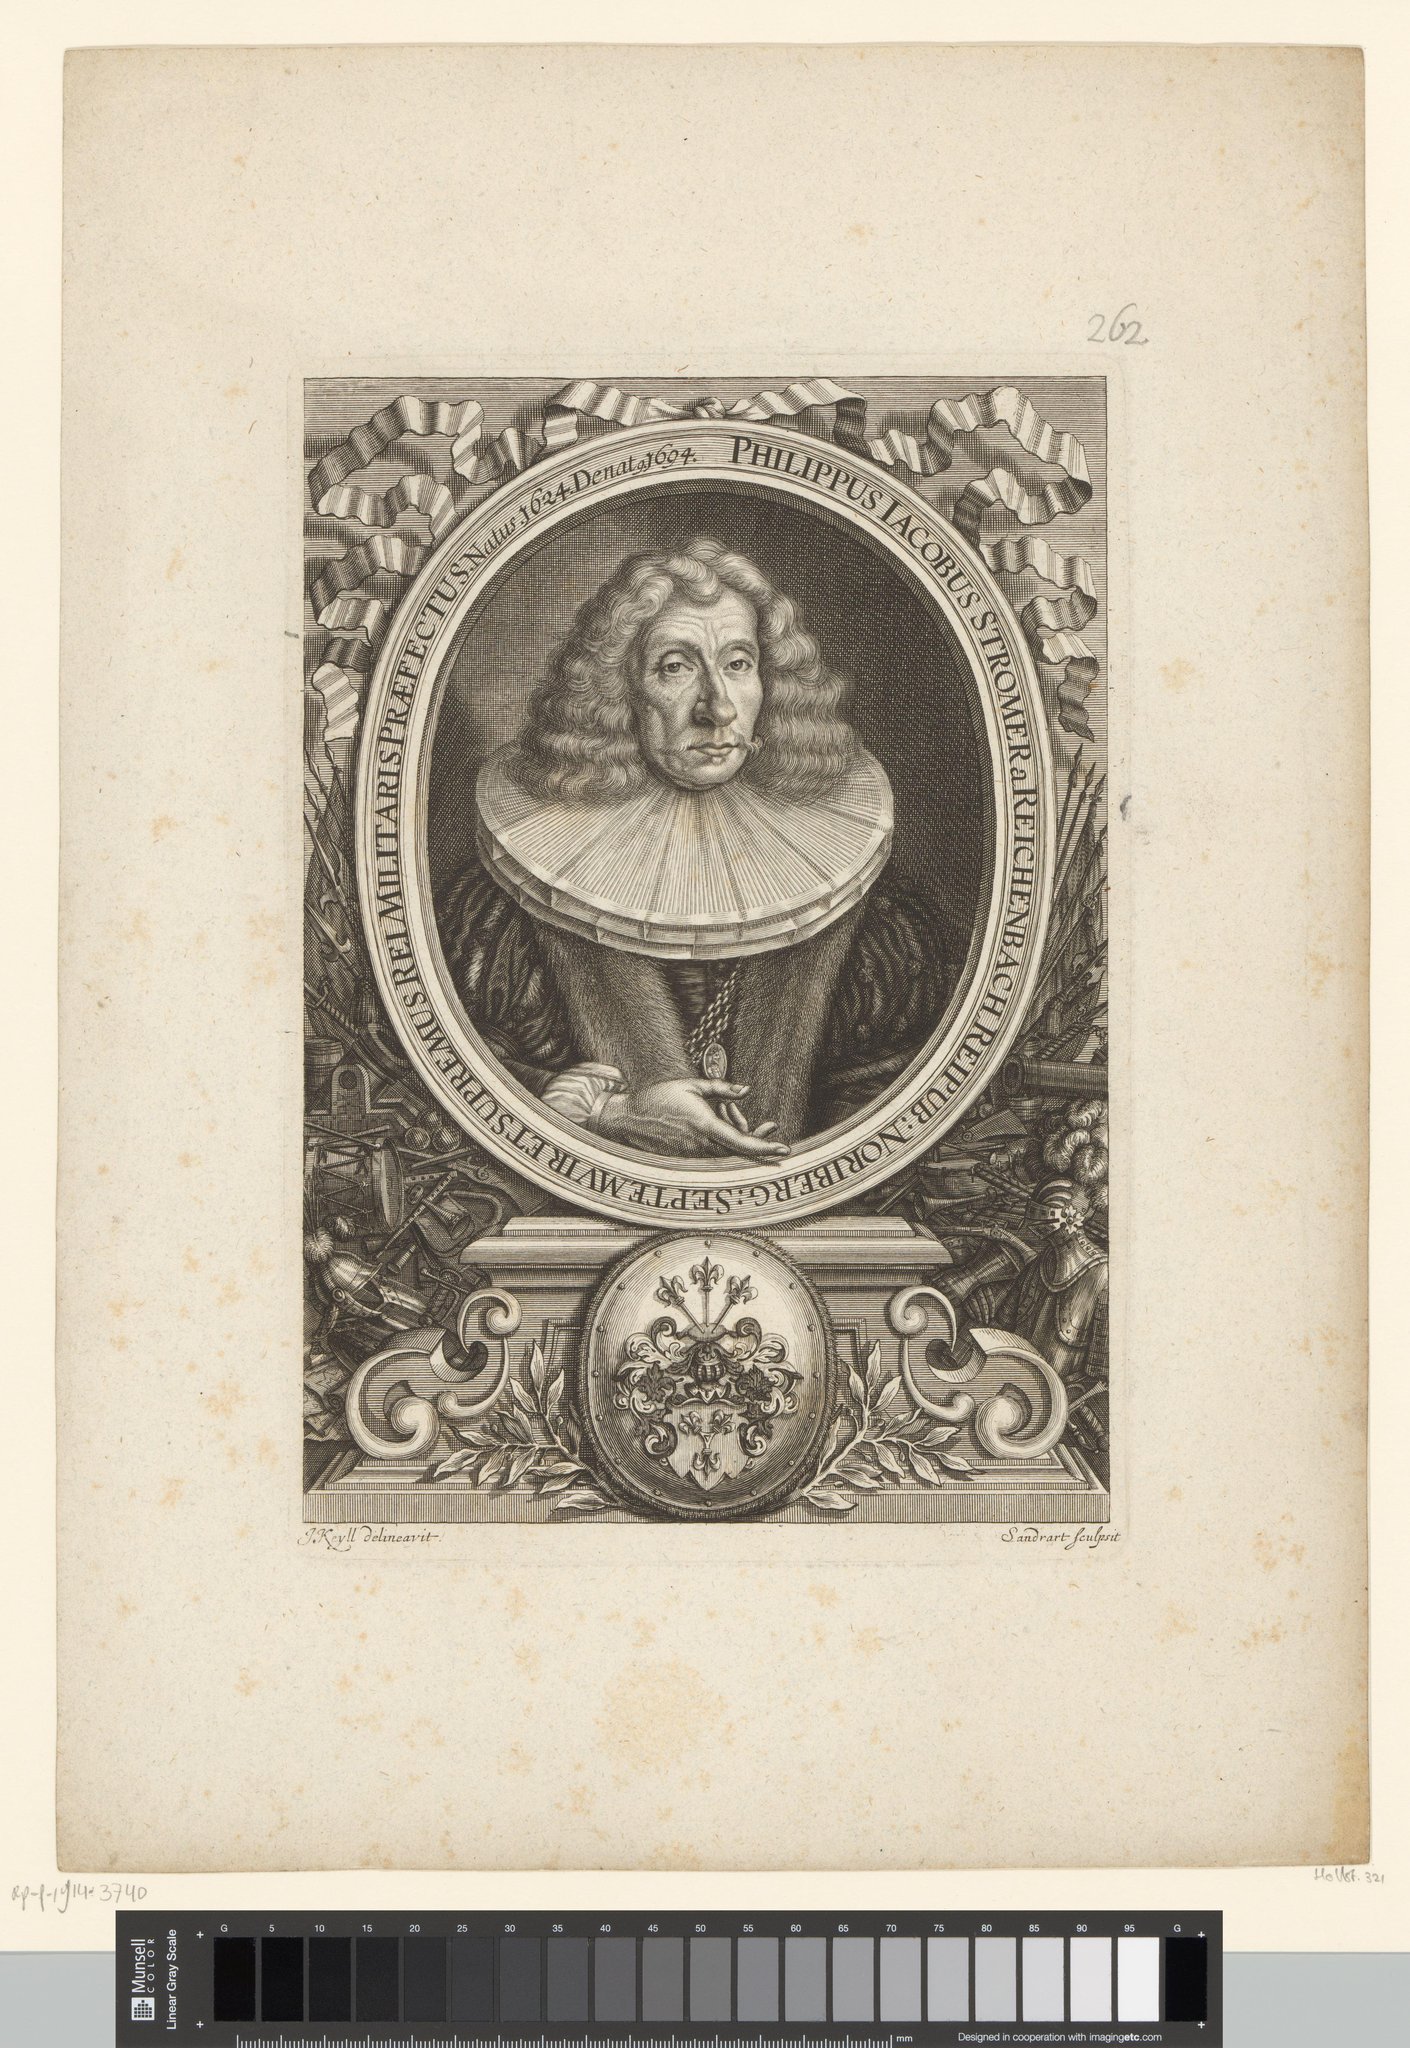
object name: print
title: Portret van Philipp Jacob Stromer von Reichenbach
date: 1694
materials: paper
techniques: engraving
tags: historical persons, symbols, allegories of war; 'guerra' (ripa), armorial bearing, heraldry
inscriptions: collector's mark: Lugt 2228